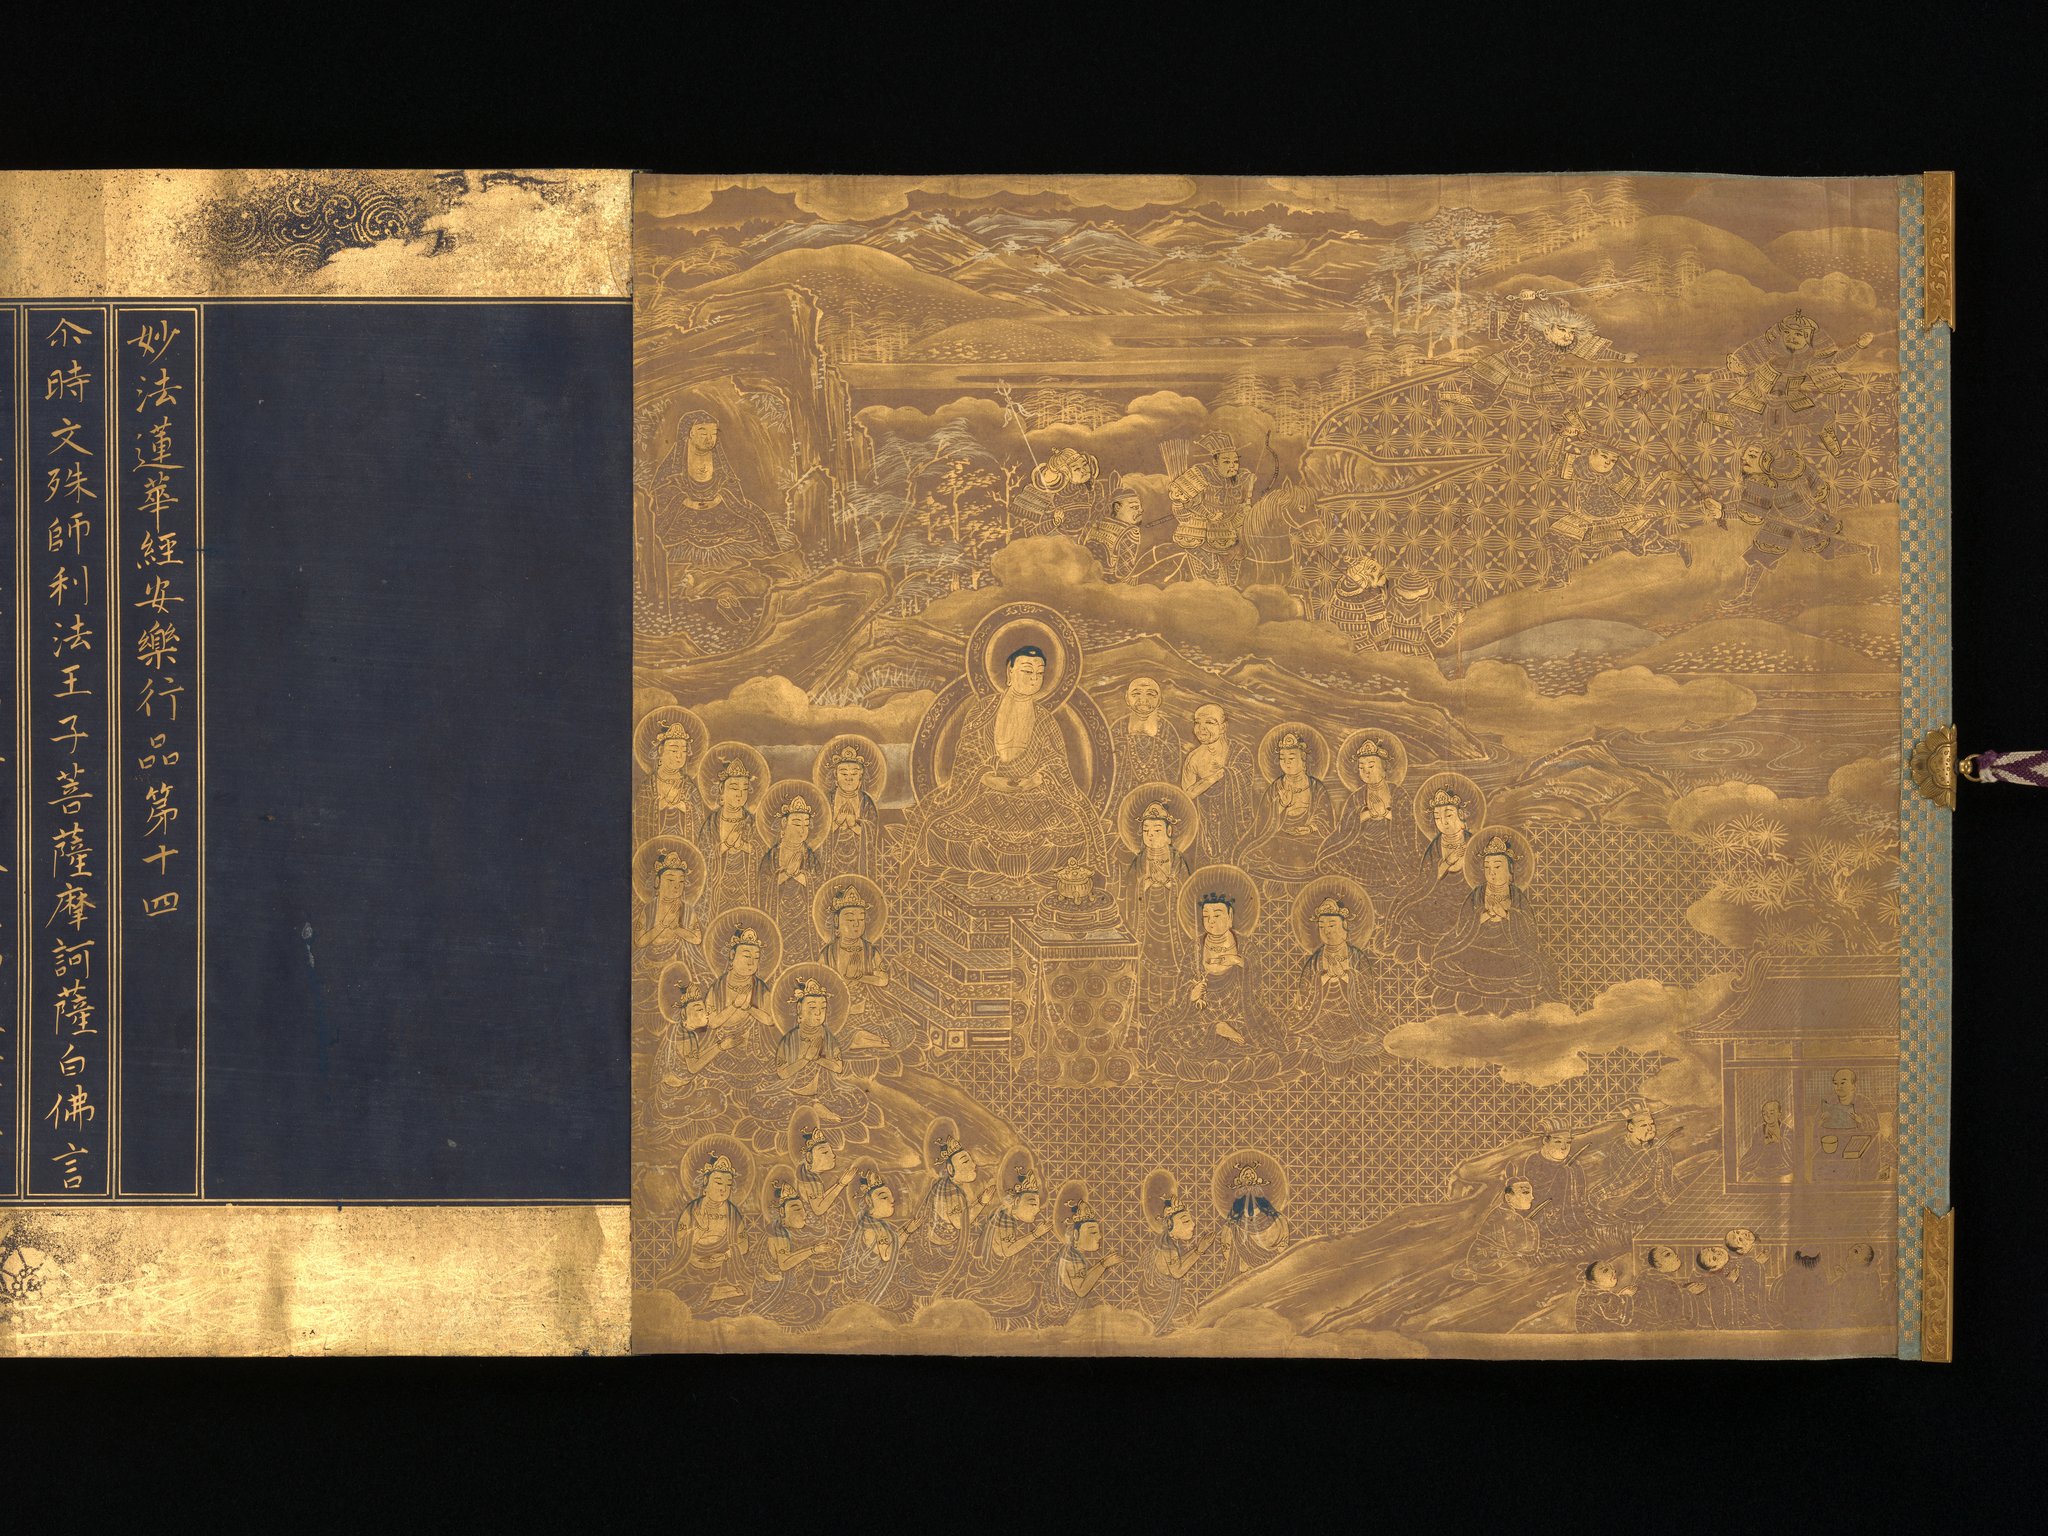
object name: handscroll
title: Lotus Sutra, Chapters 12 and 14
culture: japanese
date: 1667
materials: gold, paper, silver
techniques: dyeing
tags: men,horses,buddhism,buddha